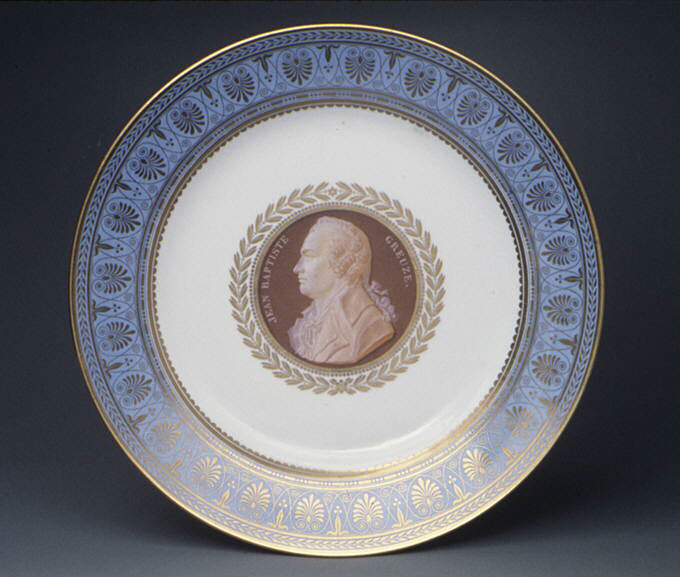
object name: plate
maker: sèvres manufactory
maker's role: manufactory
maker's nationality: french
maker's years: 1740-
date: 1833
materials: hard paste porcelain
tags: men,profiles